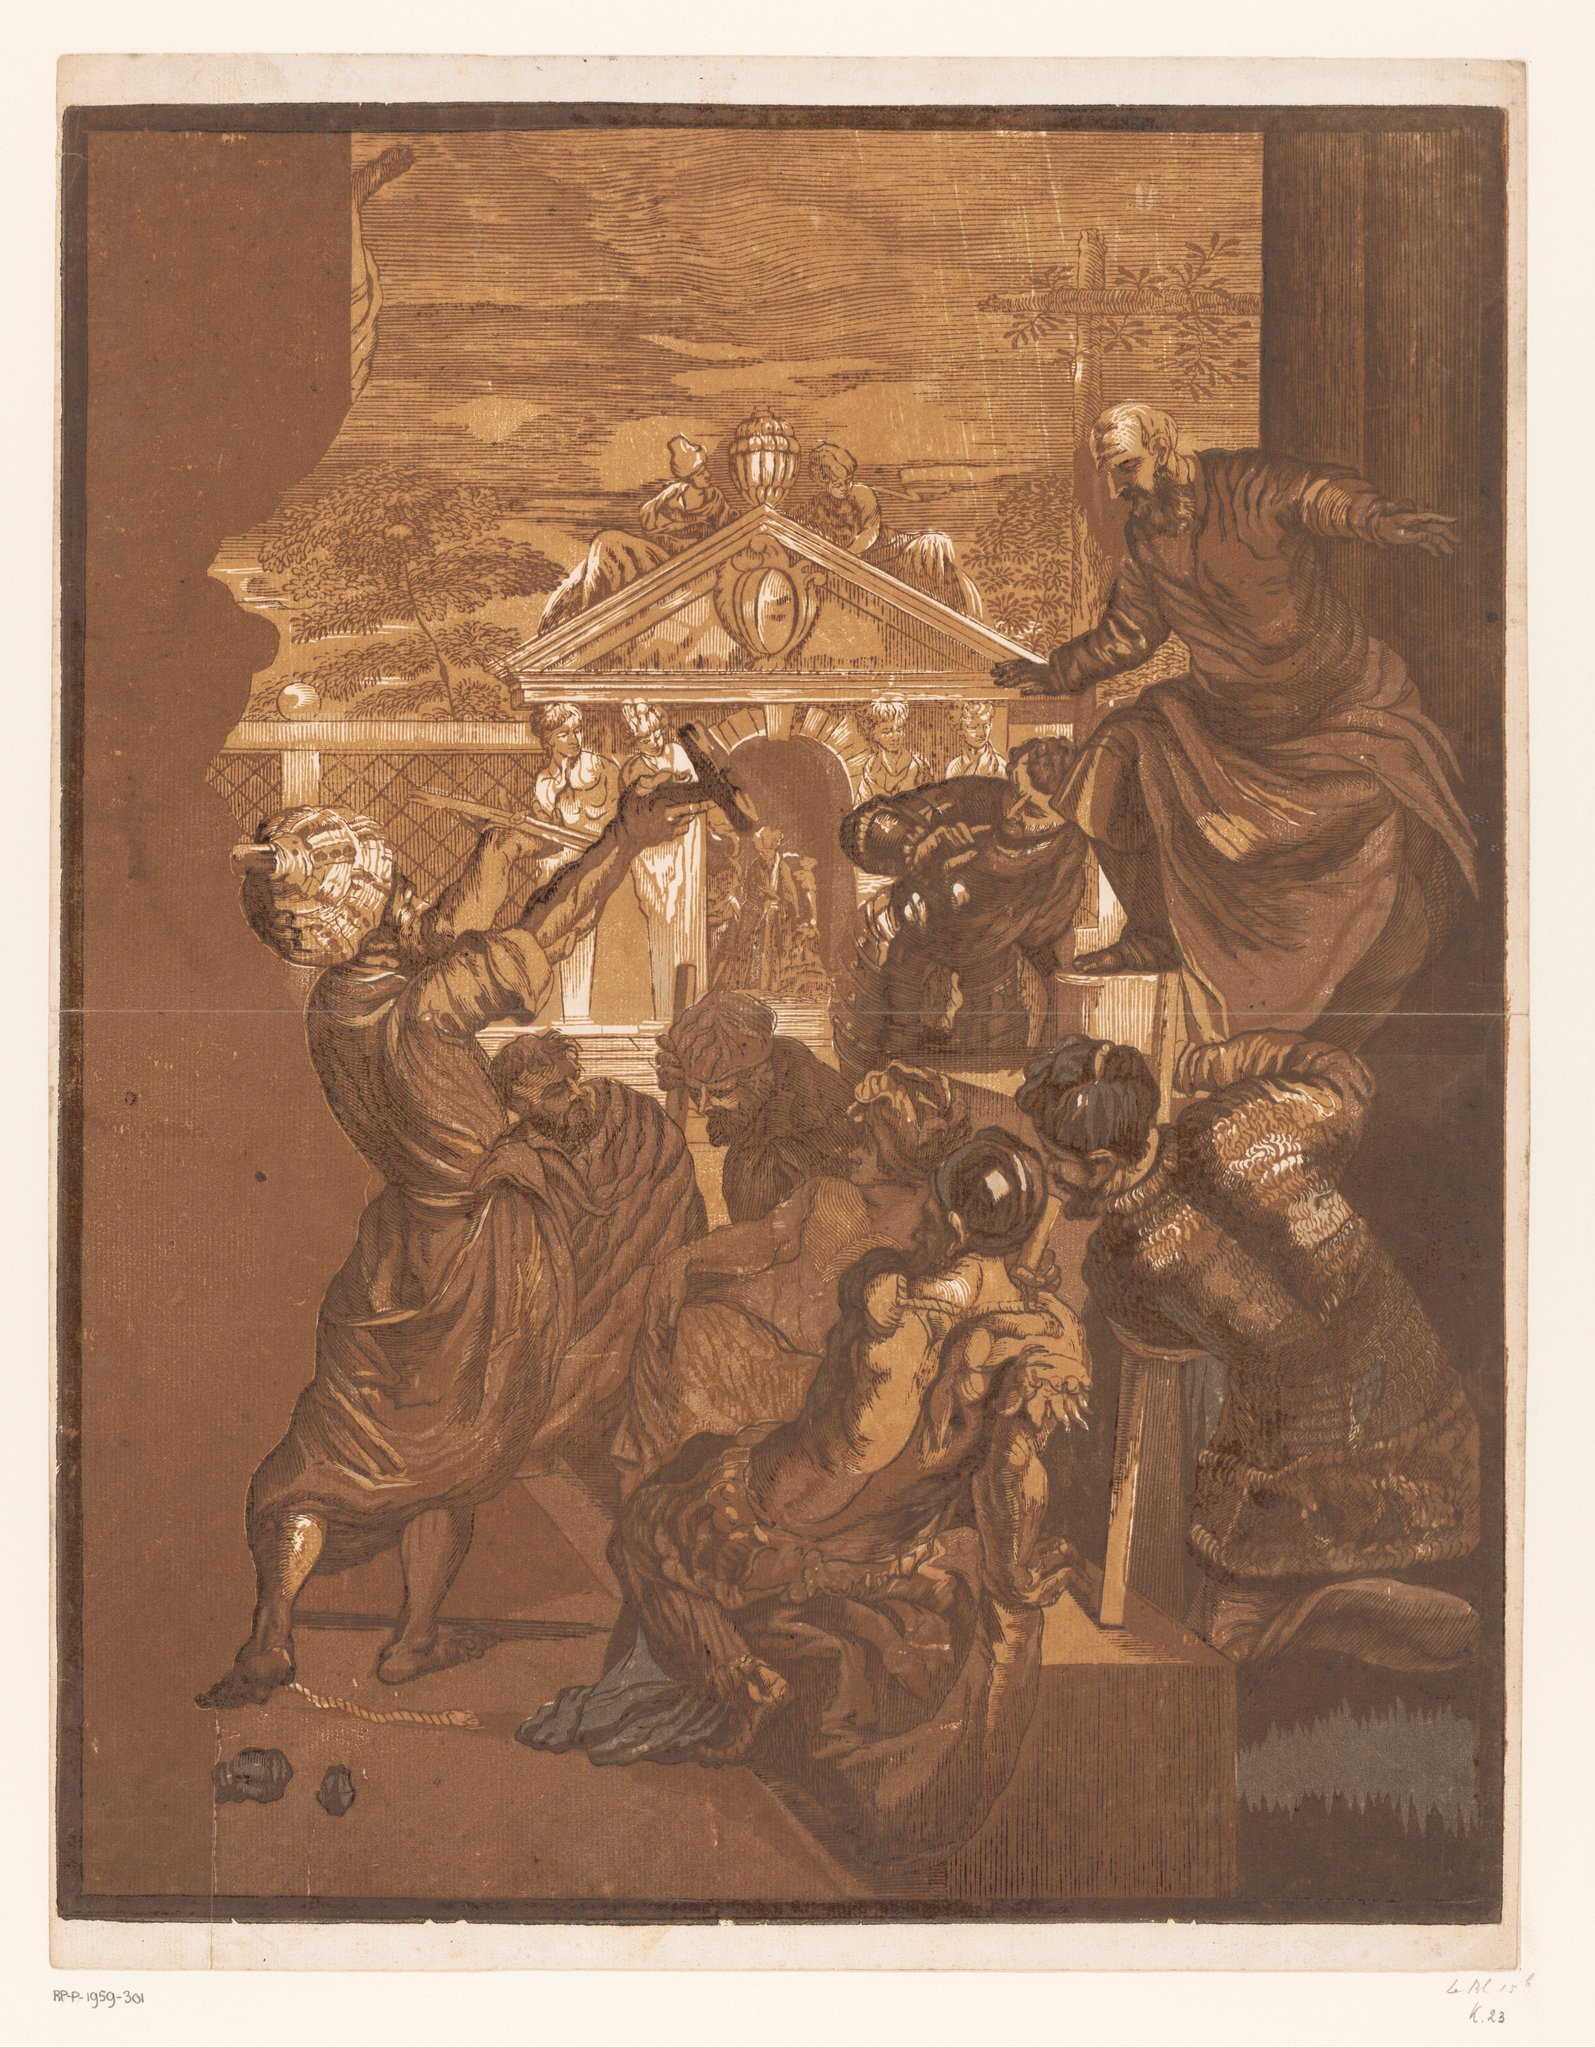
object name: print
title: Kunstwerken van Venetiaanse meesters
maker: john baptist jackson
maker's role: print maker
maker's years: 1701-1780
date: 1745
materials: paper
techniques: woodcut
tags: slavery; serfs and enslaved persons, st. mark rescues a slave from martyrdom by coming down from heaven; the instruments of torture break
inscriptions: collector's mark: Lugt 2228, collector's mark: Lugt 2760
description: Prent maakt deel uit van een ongenummerde serie van 24 prenten.